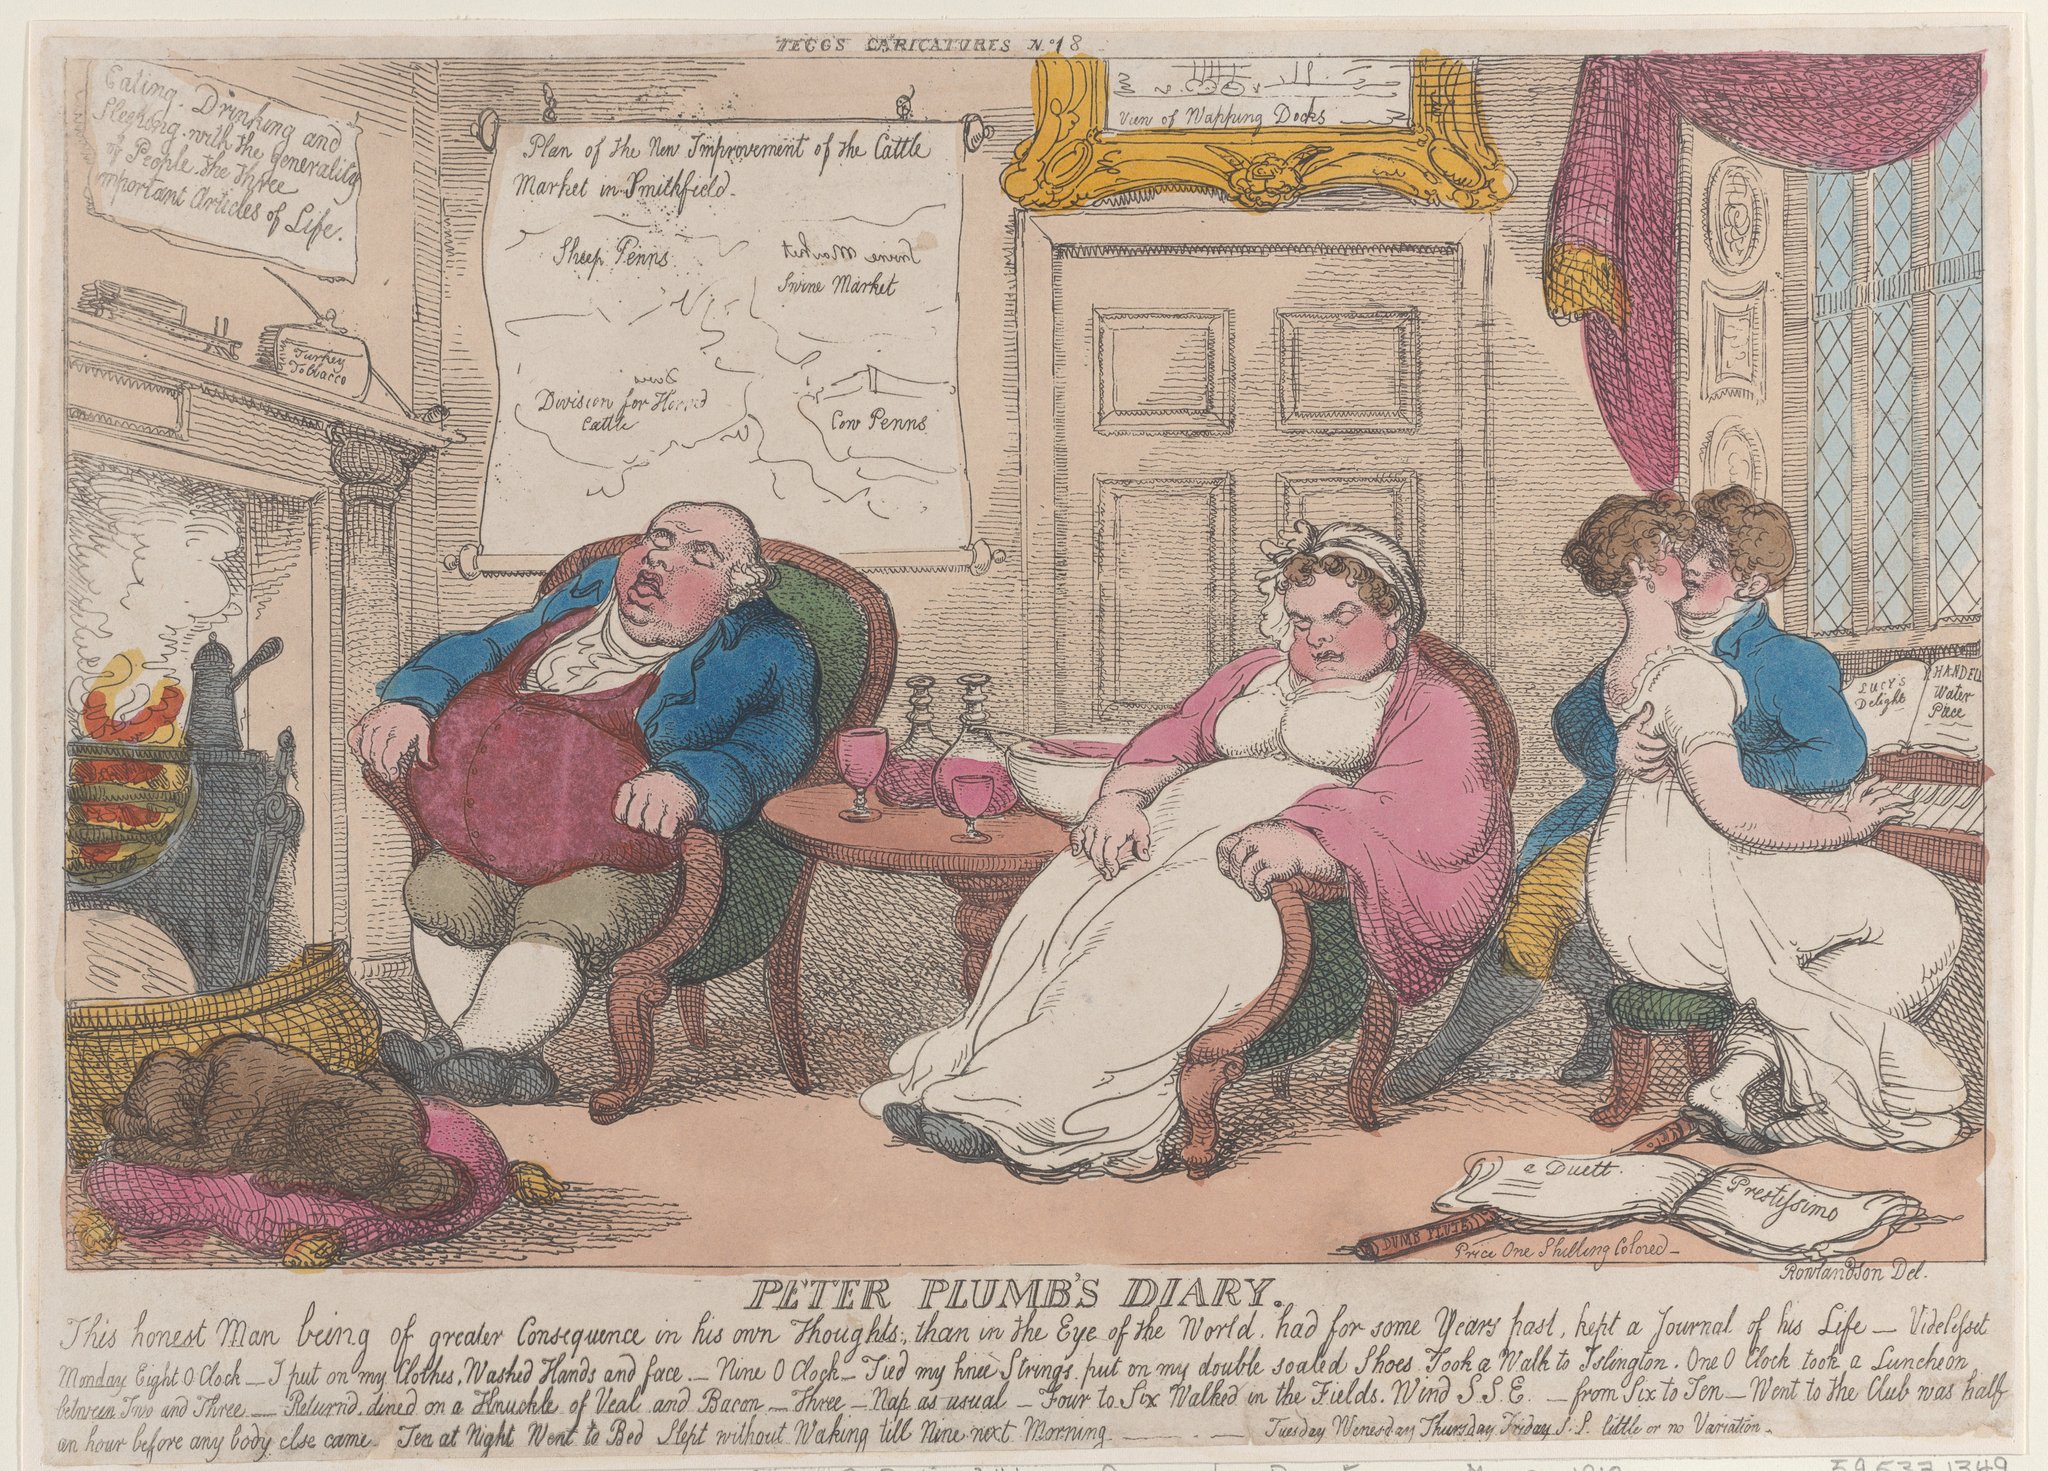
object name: print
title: Peter Plumb's Diary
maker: thomas rowlandson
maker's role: artist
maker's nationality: british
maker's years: 1757-1827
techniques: etching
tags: satire,sleeping,couples,men,women,dogs